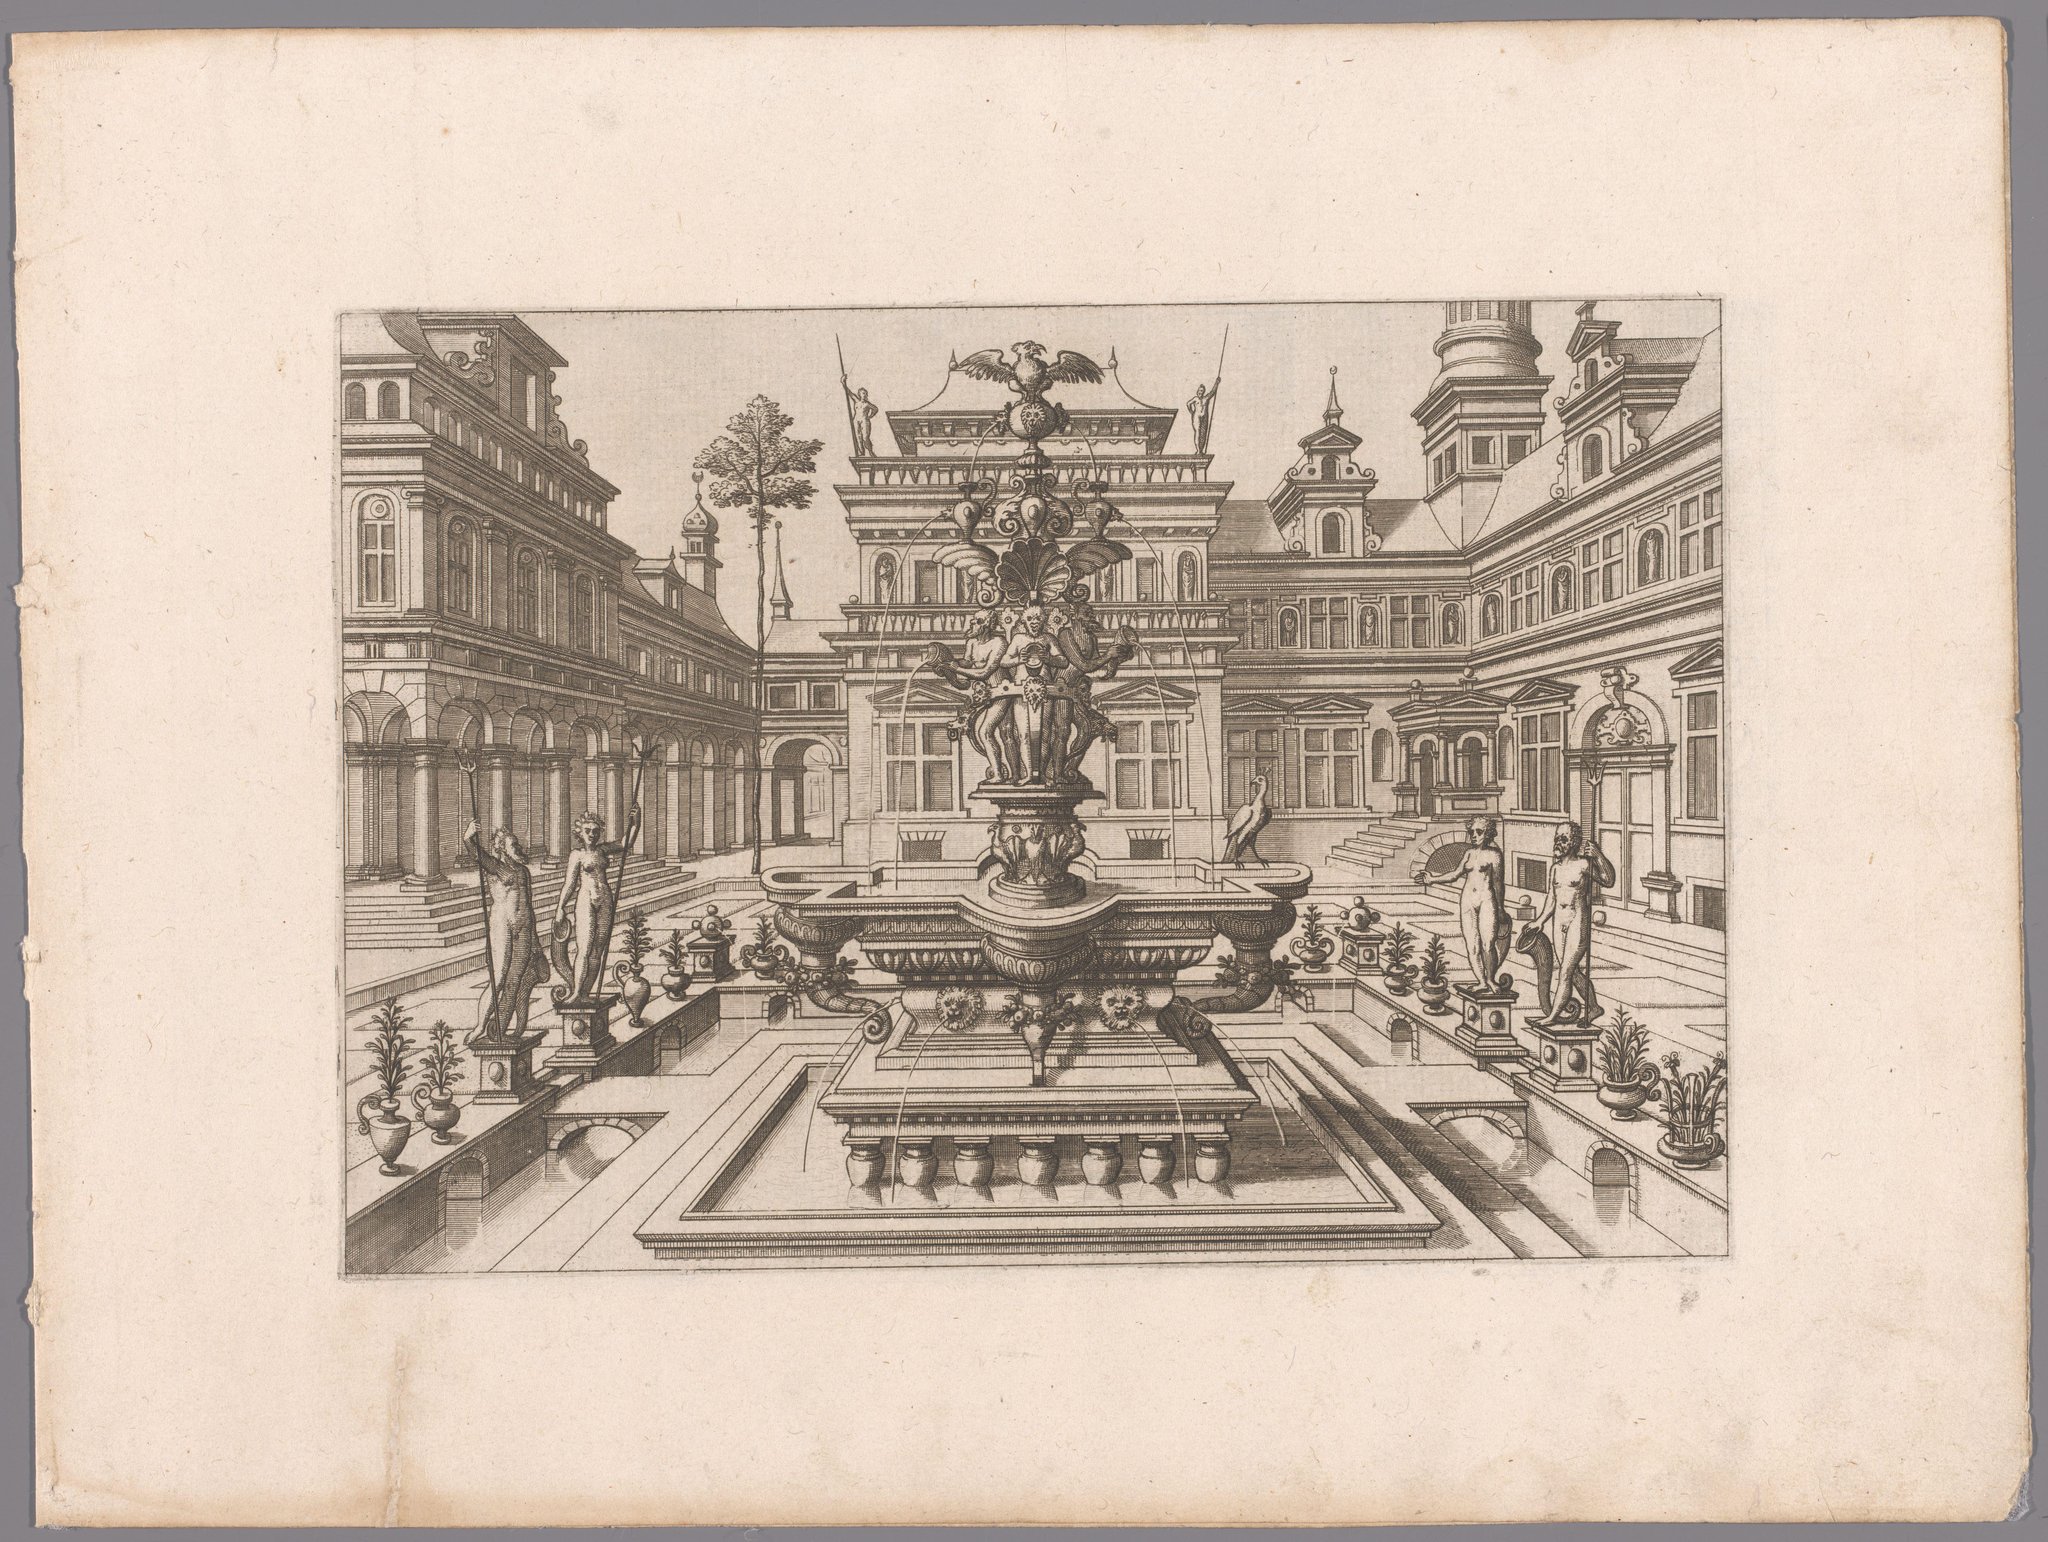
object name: print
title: Stadsplein met een fontein omgeven door beelden en potten met planten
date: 1568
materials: paper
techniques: etching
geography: antwerp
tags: piece of sculpture, reproduction of a piece of sculpture, ornamental fountain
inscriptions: watermark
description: Stadsplein met een fontein op een vierkante basis omgeven door beelden en potten met planten. Vier saters maken deel uit van de fontein.